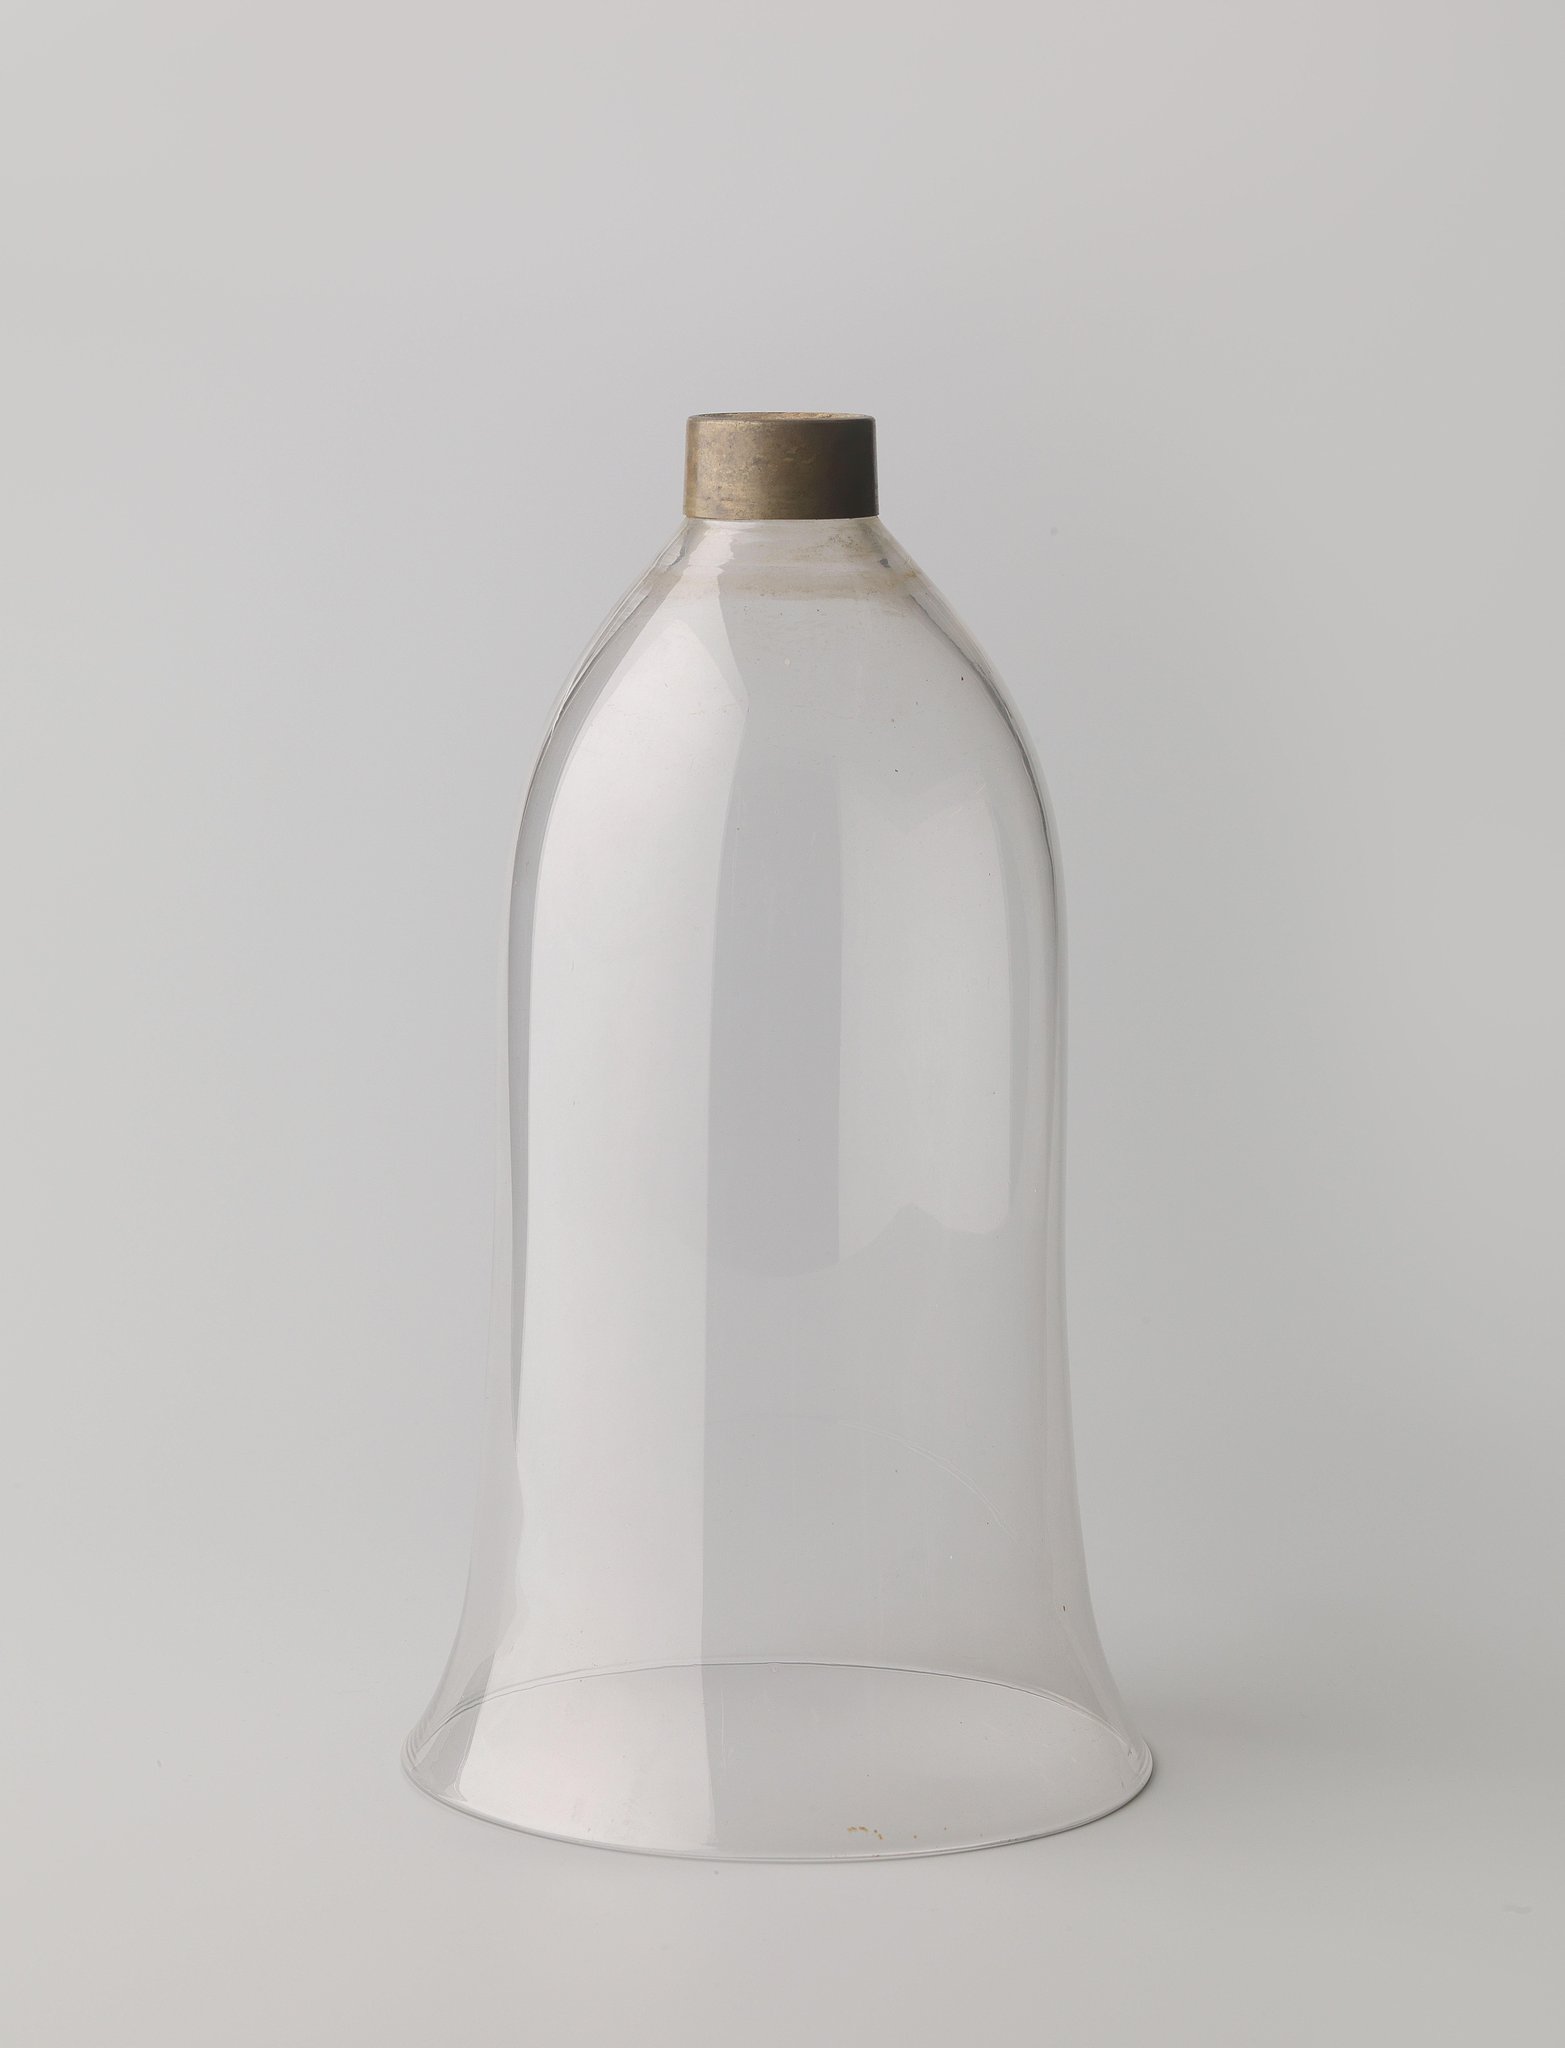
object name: lighting device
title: Glazen kap van wandarm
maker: Anonymous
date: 1820-1830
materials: copper, glass, wood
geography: indonesia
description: De koperen ring aan de onderzijde van de hoge, open, glazen kap.